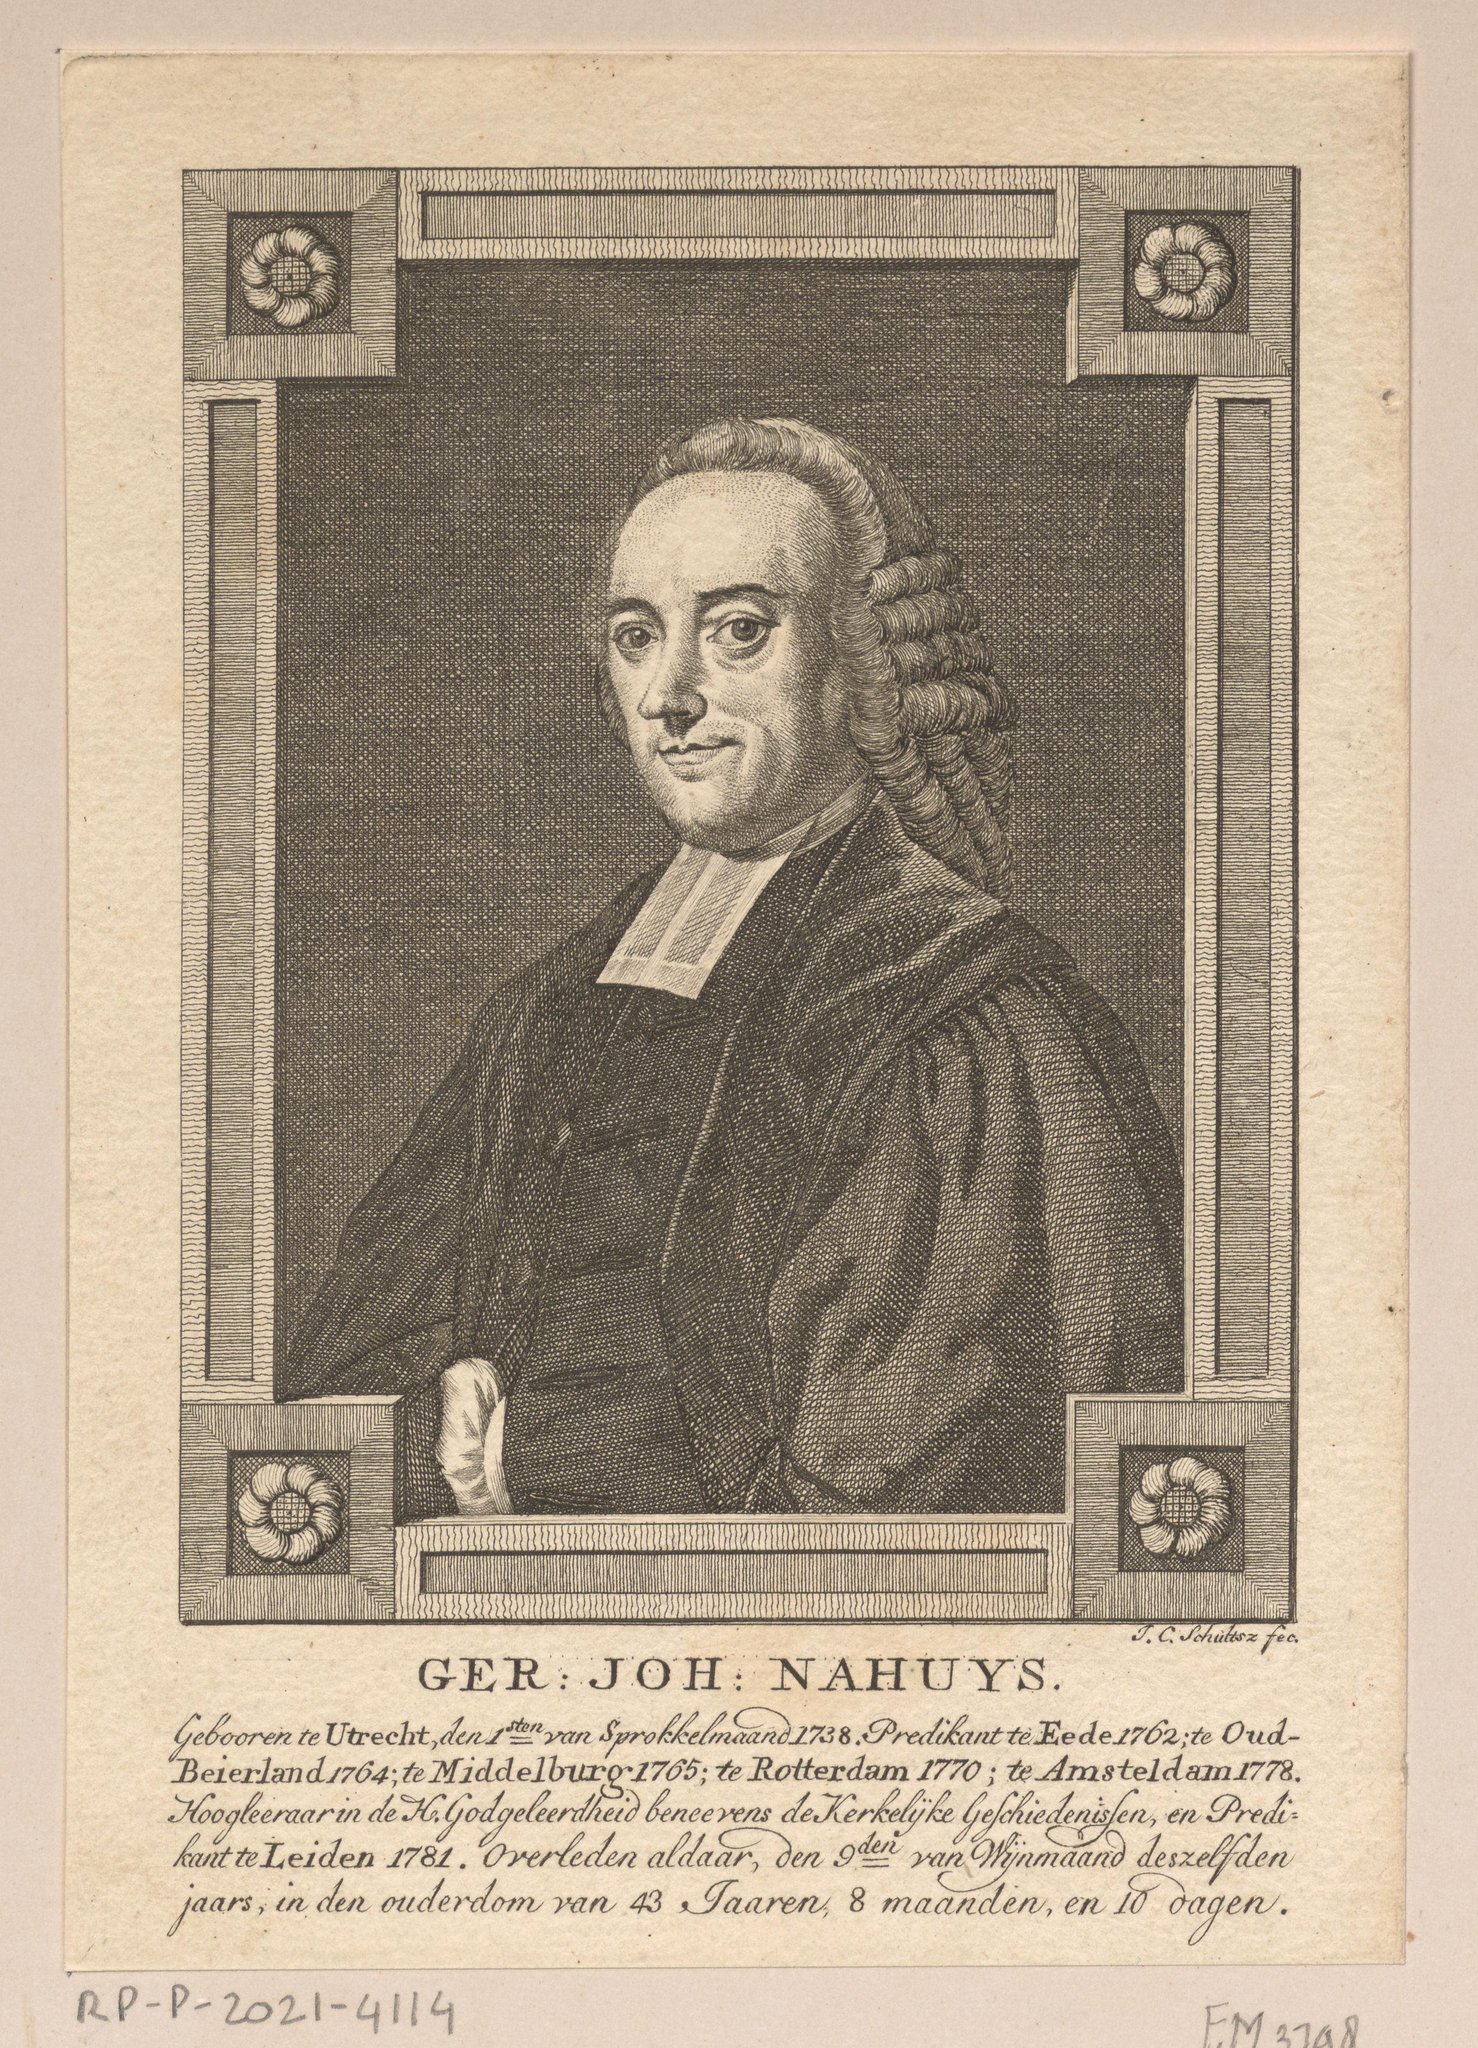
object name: print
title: Portret van Gerard Johan Nahuys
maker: johan christoffel schultsz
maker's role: print maker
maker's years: 1749-1812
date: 1781-1812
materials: paper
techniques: engraving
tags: utrecht, leiden, theologian, historical persons, professor